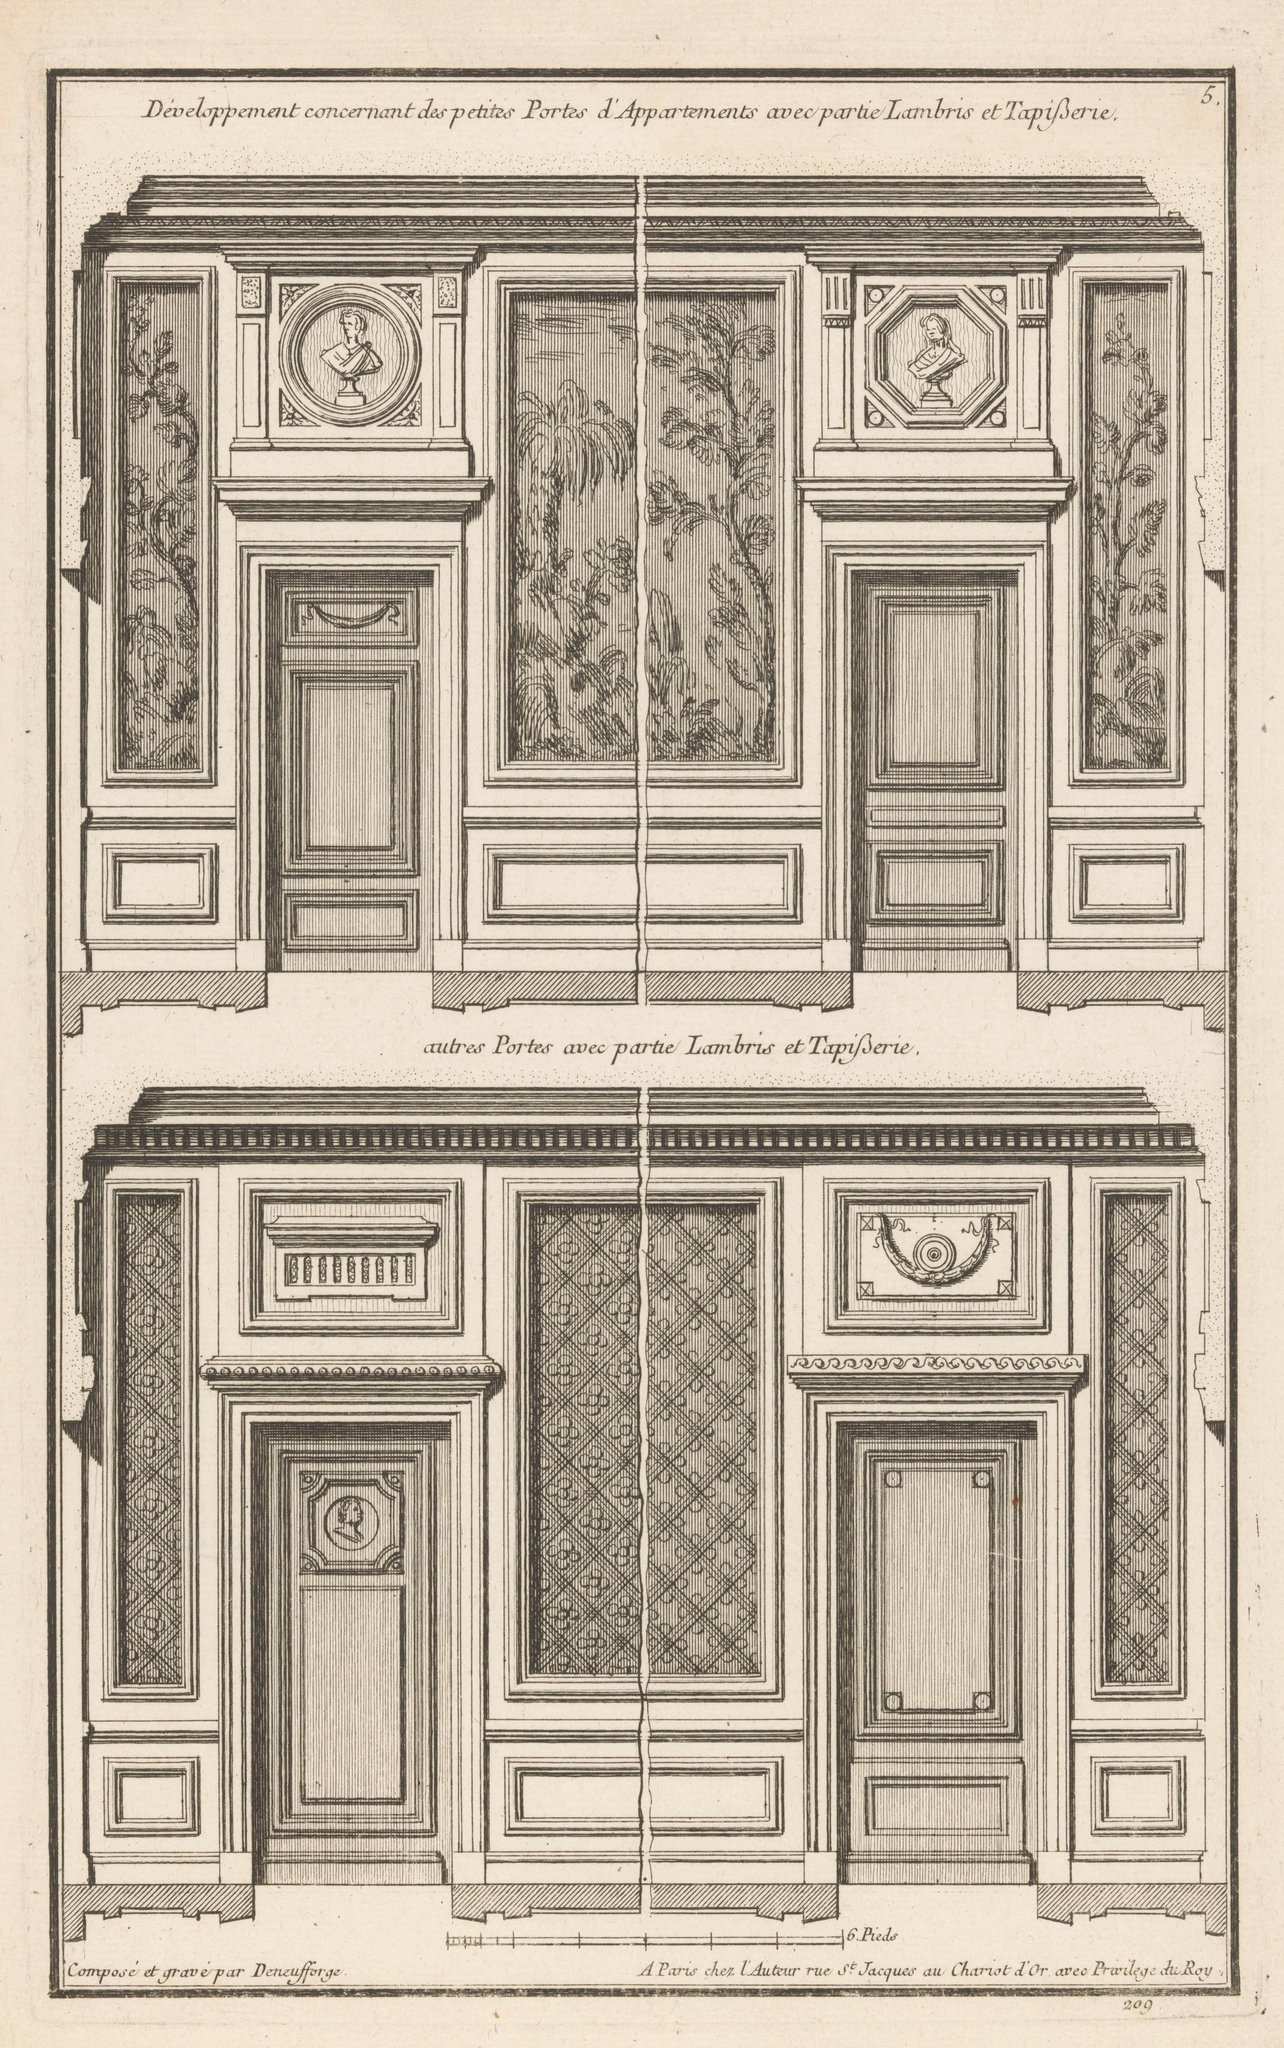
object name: print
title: Développement concernant des petites Portes d'Appartements avec partie Lambris et Tapiβerie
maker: jean françois de neufforge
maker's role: print maker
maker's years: 1714-1791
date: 1760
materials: paper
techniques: etching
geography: paris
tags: door, tapestry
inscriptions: collector's mark: Lugt 2228, collector's mark: Lugt 2760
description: Twee wanddecoraties met deuren met dessus-de-portes en wandtapijten met landschappen en een bloemenpatroon. Prentnummer 209.